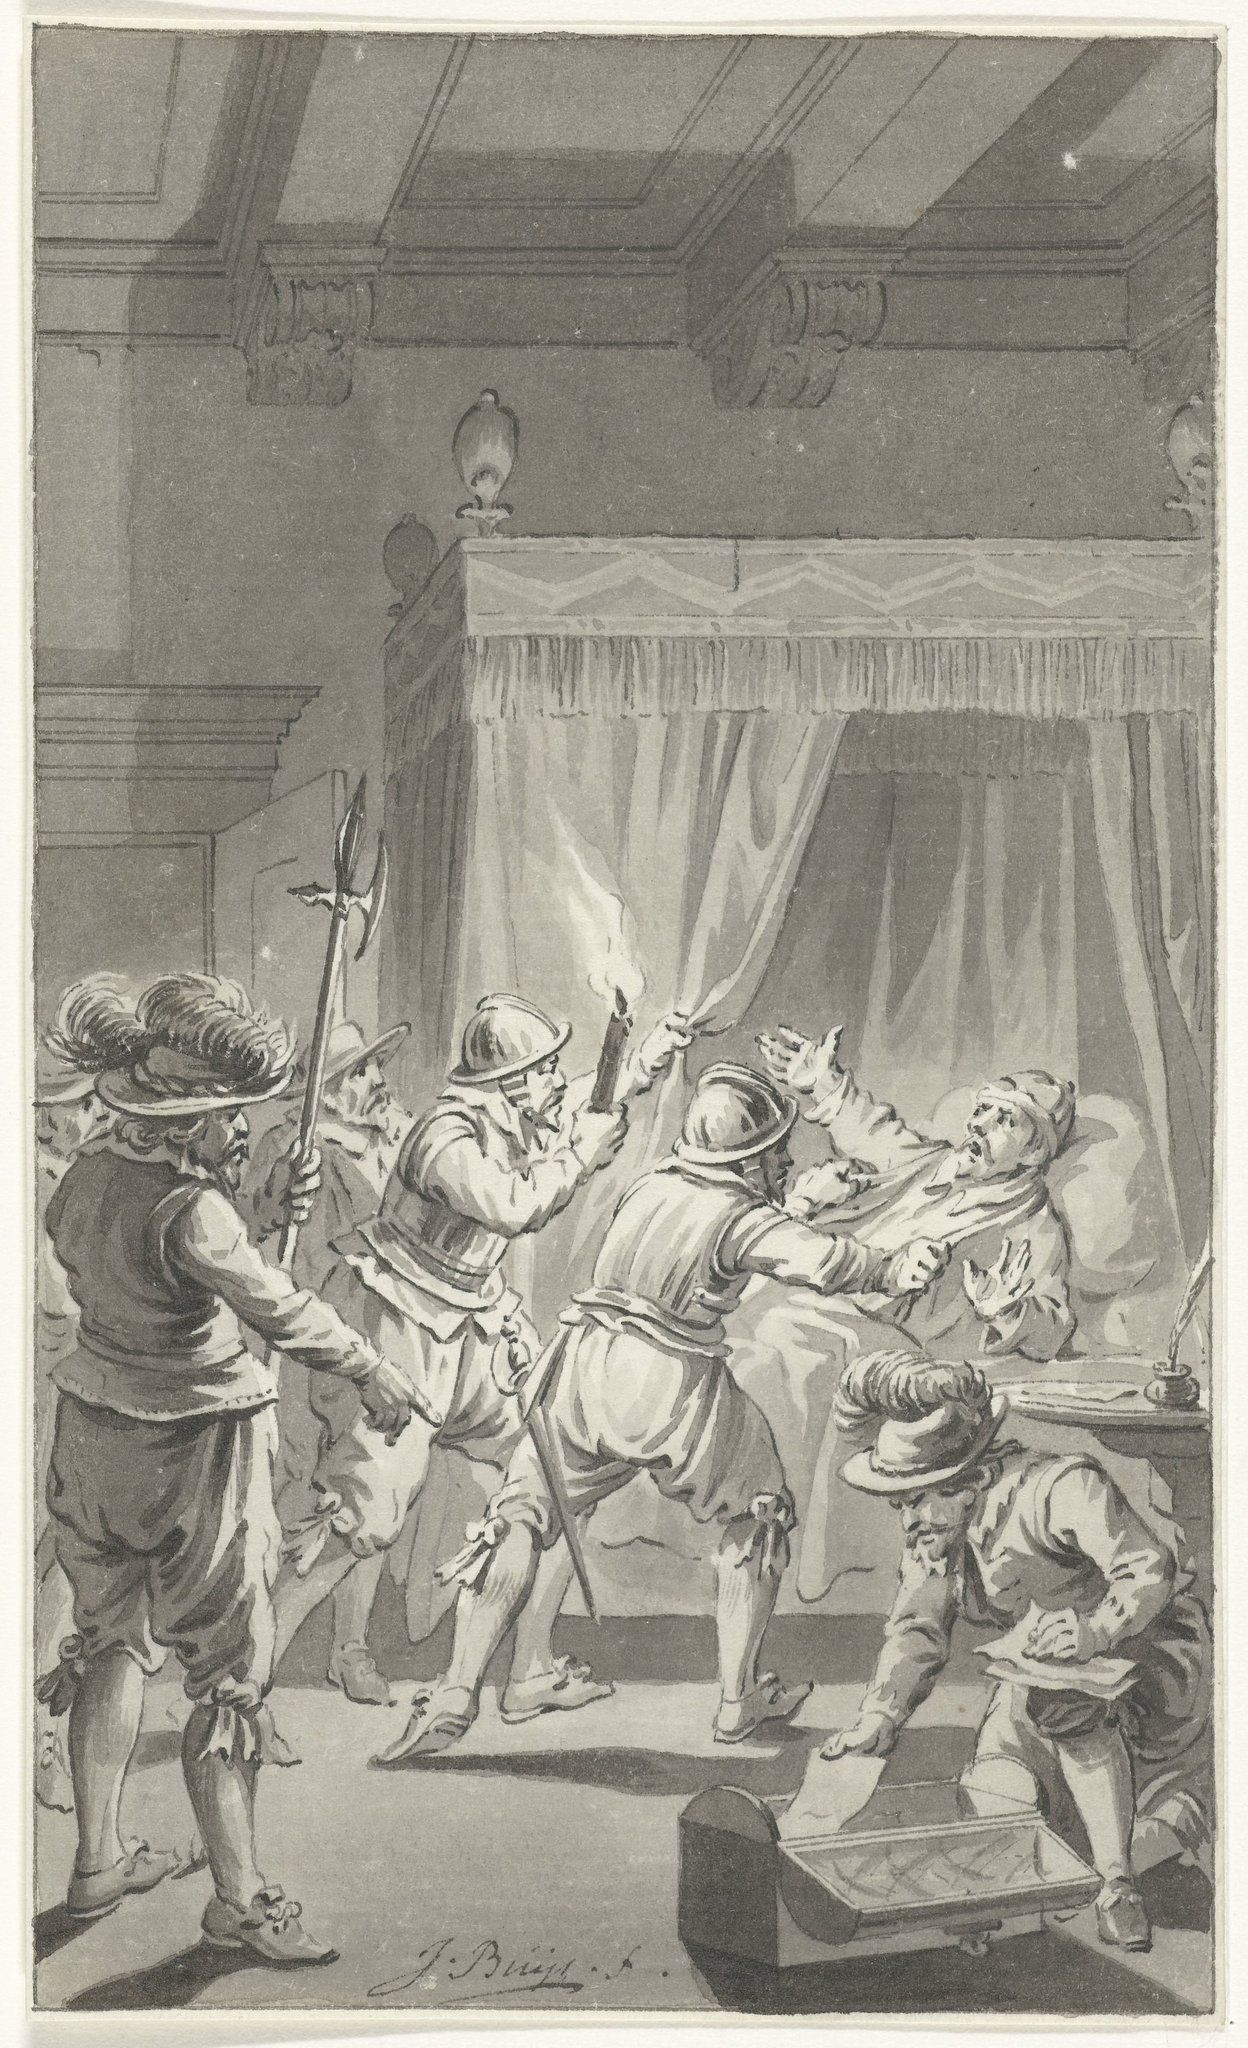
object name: design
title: De arrestatie van Paulus Buis, pensionaris van Utrecht, 19 juli 1586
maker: jacobus buys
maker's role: draughtsman, print maker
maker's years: 1724-1801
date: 1785-1787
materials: ink, paper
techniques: brush, pen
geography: netherlands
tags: robert dudley (1st earl of leicester), historical persons, bed, arrest (of criminal), historical events and situations, utrecht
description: Paulus Buis, pensionaris van Utrecht, 's nachts op bevel van de graaf van Leicester in zijn slaapkamer, gevangengenomen, 19 juli 1586. Ontwerp voor een prent.